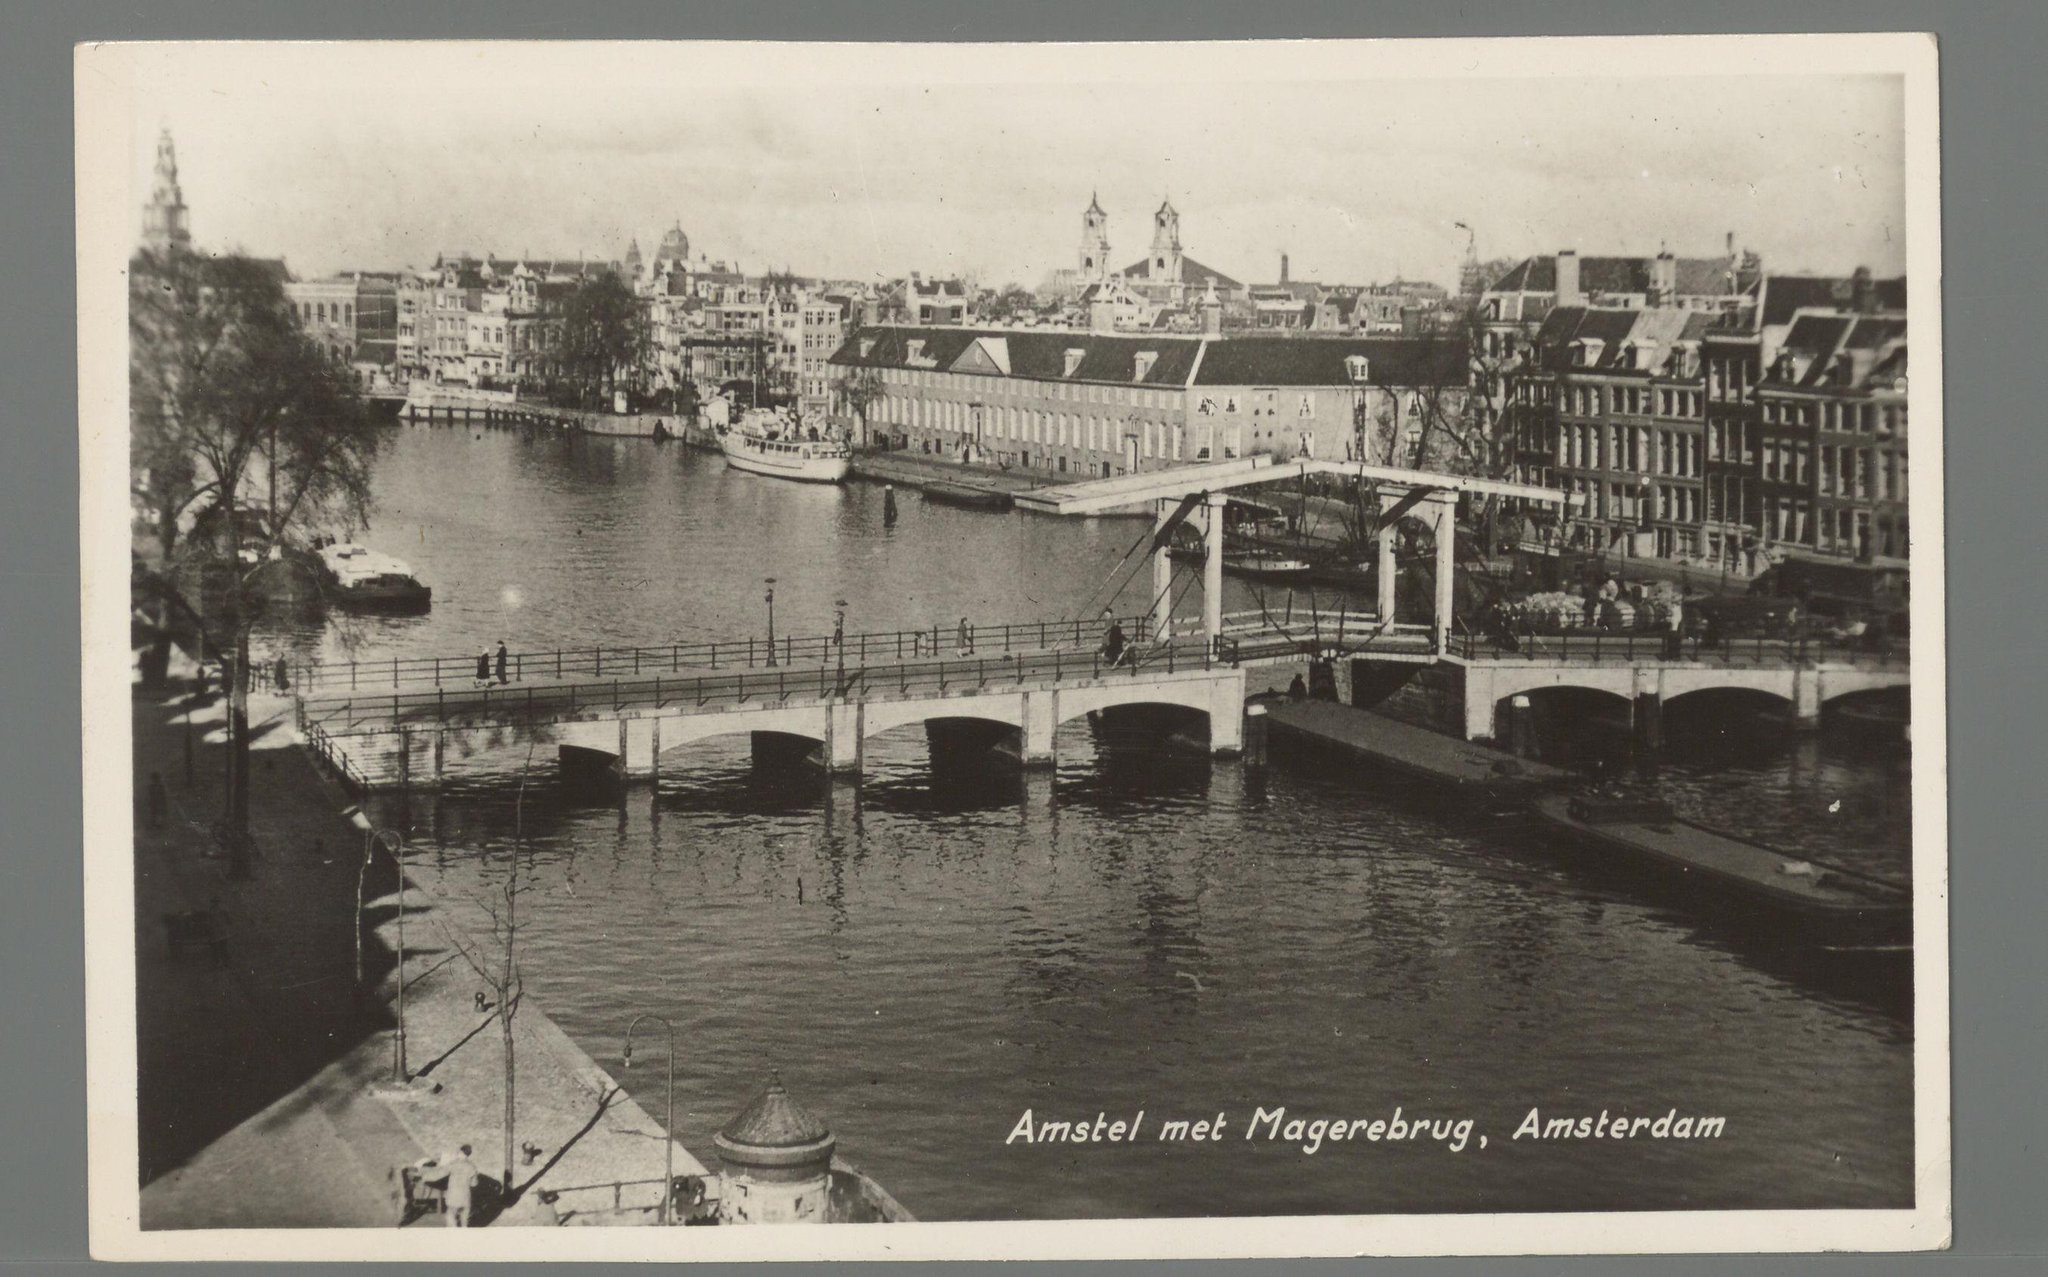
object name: photograph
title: Amstel met Magerebrug, Amsterdam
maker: Anonymous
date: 1929-1952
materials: photographic support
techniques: photography, writing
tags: bridge in city across river, canal, etc.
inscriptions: postage stamp